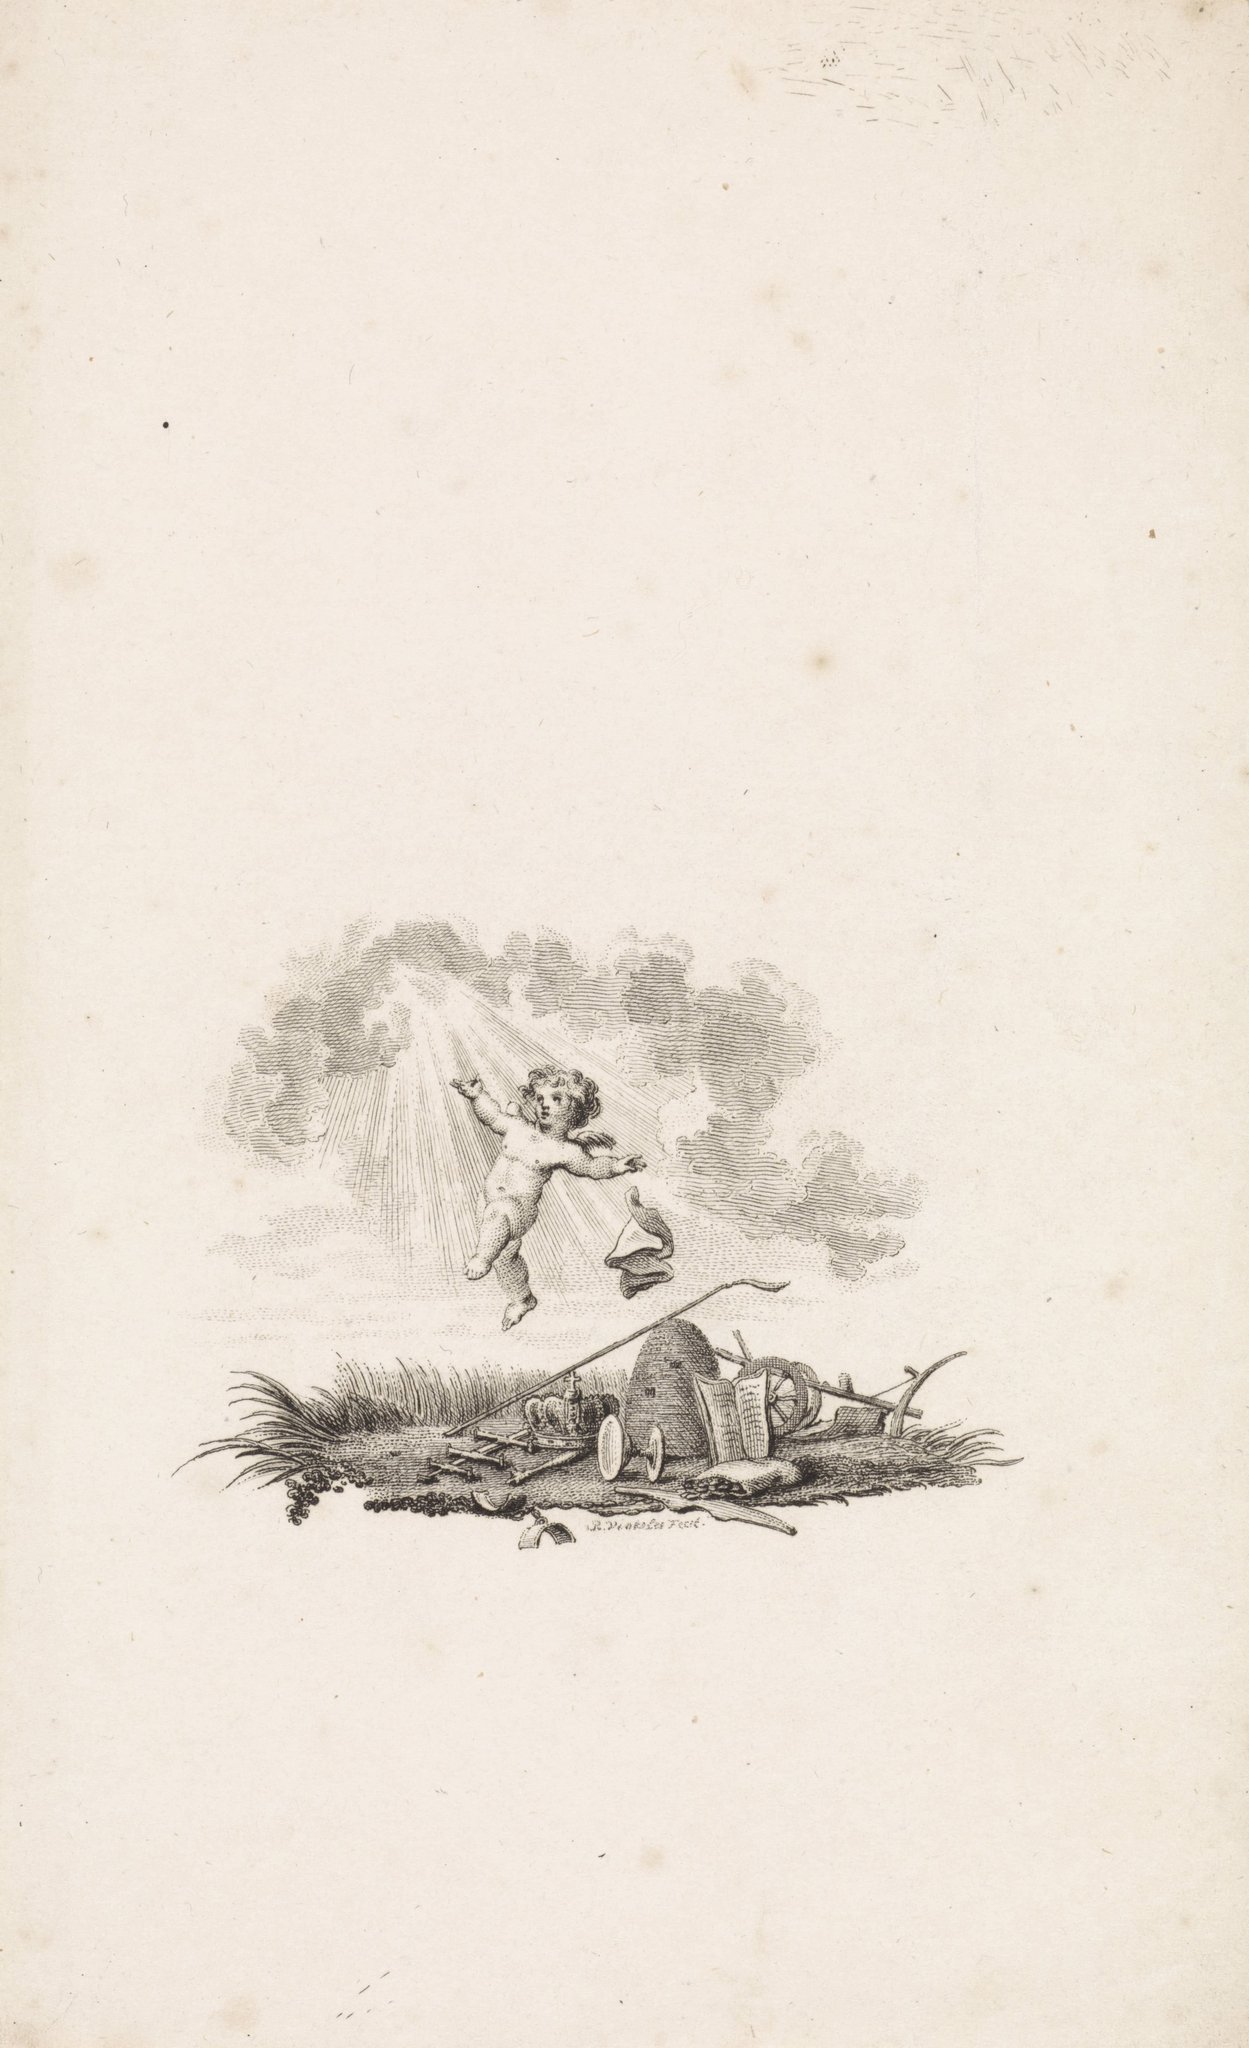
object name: print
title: Putto zwevend boven een landschap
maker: reinier vinkeles (i)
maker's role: draughtsman, print maker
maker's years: 1741-1816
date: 1751-1816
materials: paper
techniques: engraving, etching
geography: amsterdam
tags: crown (symbol of sovereignty), landscapes, book, bee-hive, cupids: 'amores', 'amoretti', 'putti'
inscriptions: collector's mark: Lugt 2228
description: Boven een landschap zweeft een putto in de stralen van de zon. Op de grond liggen attributen waaronder een bijenkorf, een boek en een kroon.